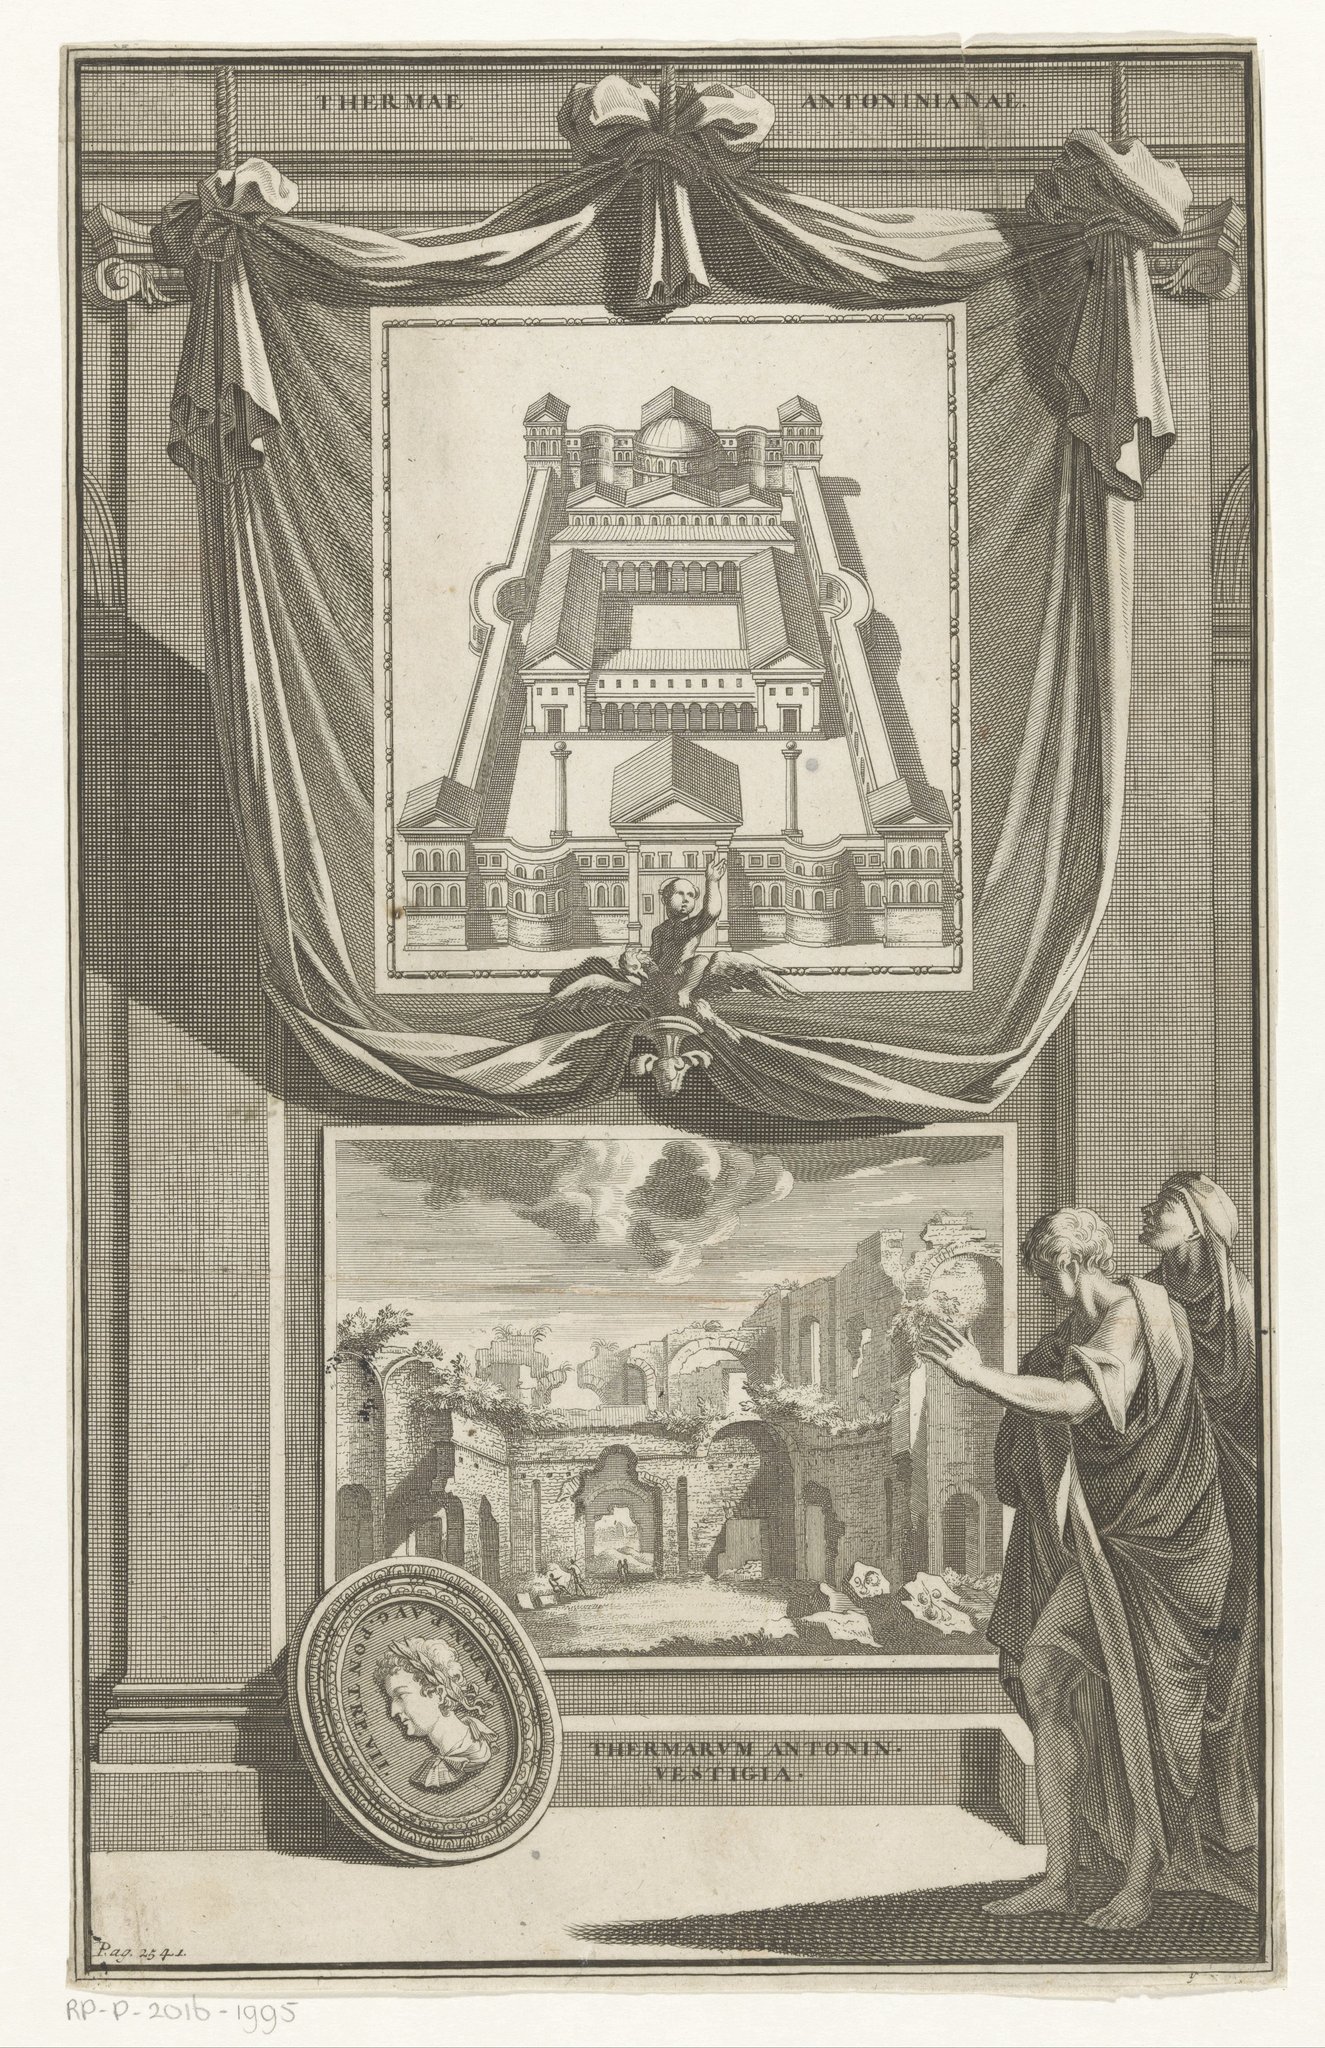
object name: print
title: Thermae Antoninianae / Thermarum antonin. vestigia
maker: Anonymous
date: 1675-1725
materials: paper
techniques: engraving, etching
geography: netherlands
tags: landscape with ruins, public baths, representation of real building (either existing or having existed)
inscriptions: collector's mark: Lugt 2228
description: Prent (zonder paginanummer) komt voor in: Desseine, Francois. Beschryving van oud en nieuw Rome, verdeelt in drie deelen. Dl. 1. Amsterdam: Halma, François, 1704. Prent afkomstig uit een plakalbum met titelprenten, ornamenten etc. op blauw papier in 1983 uit elkaar gehaald. Volgens een notitie op verso zat de prent op p. 206 van dit album.